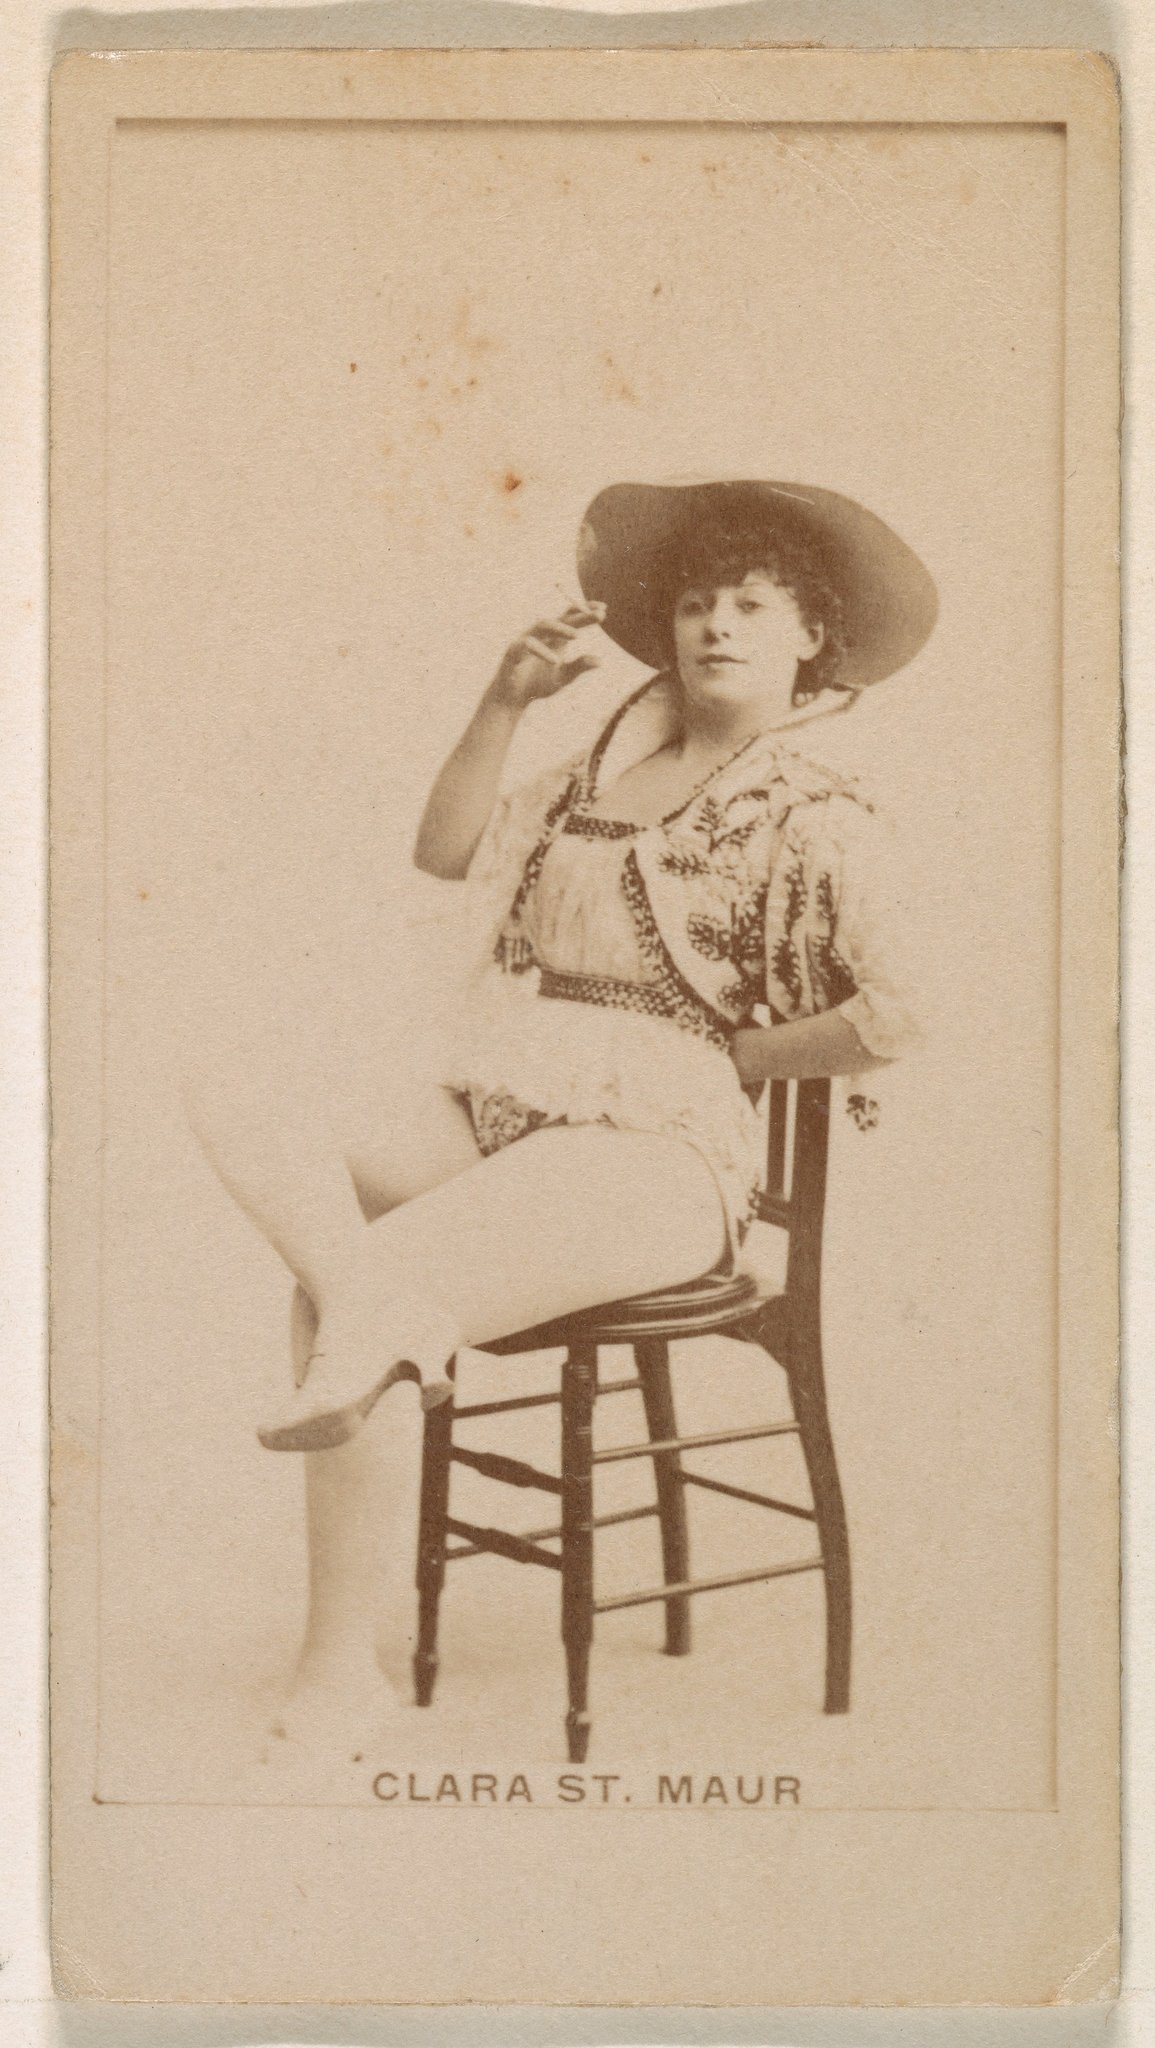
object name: photograph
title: Clara St. Maur, from the Actresses series (N245) issued by Kinney Brothers to promote Sweet Caporal Cigarettes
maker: kinney brothers tobacco company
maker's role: publisher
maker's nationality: american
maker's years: 1869-2011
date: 1890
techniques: albumen silver print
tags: portraits,women,actresses